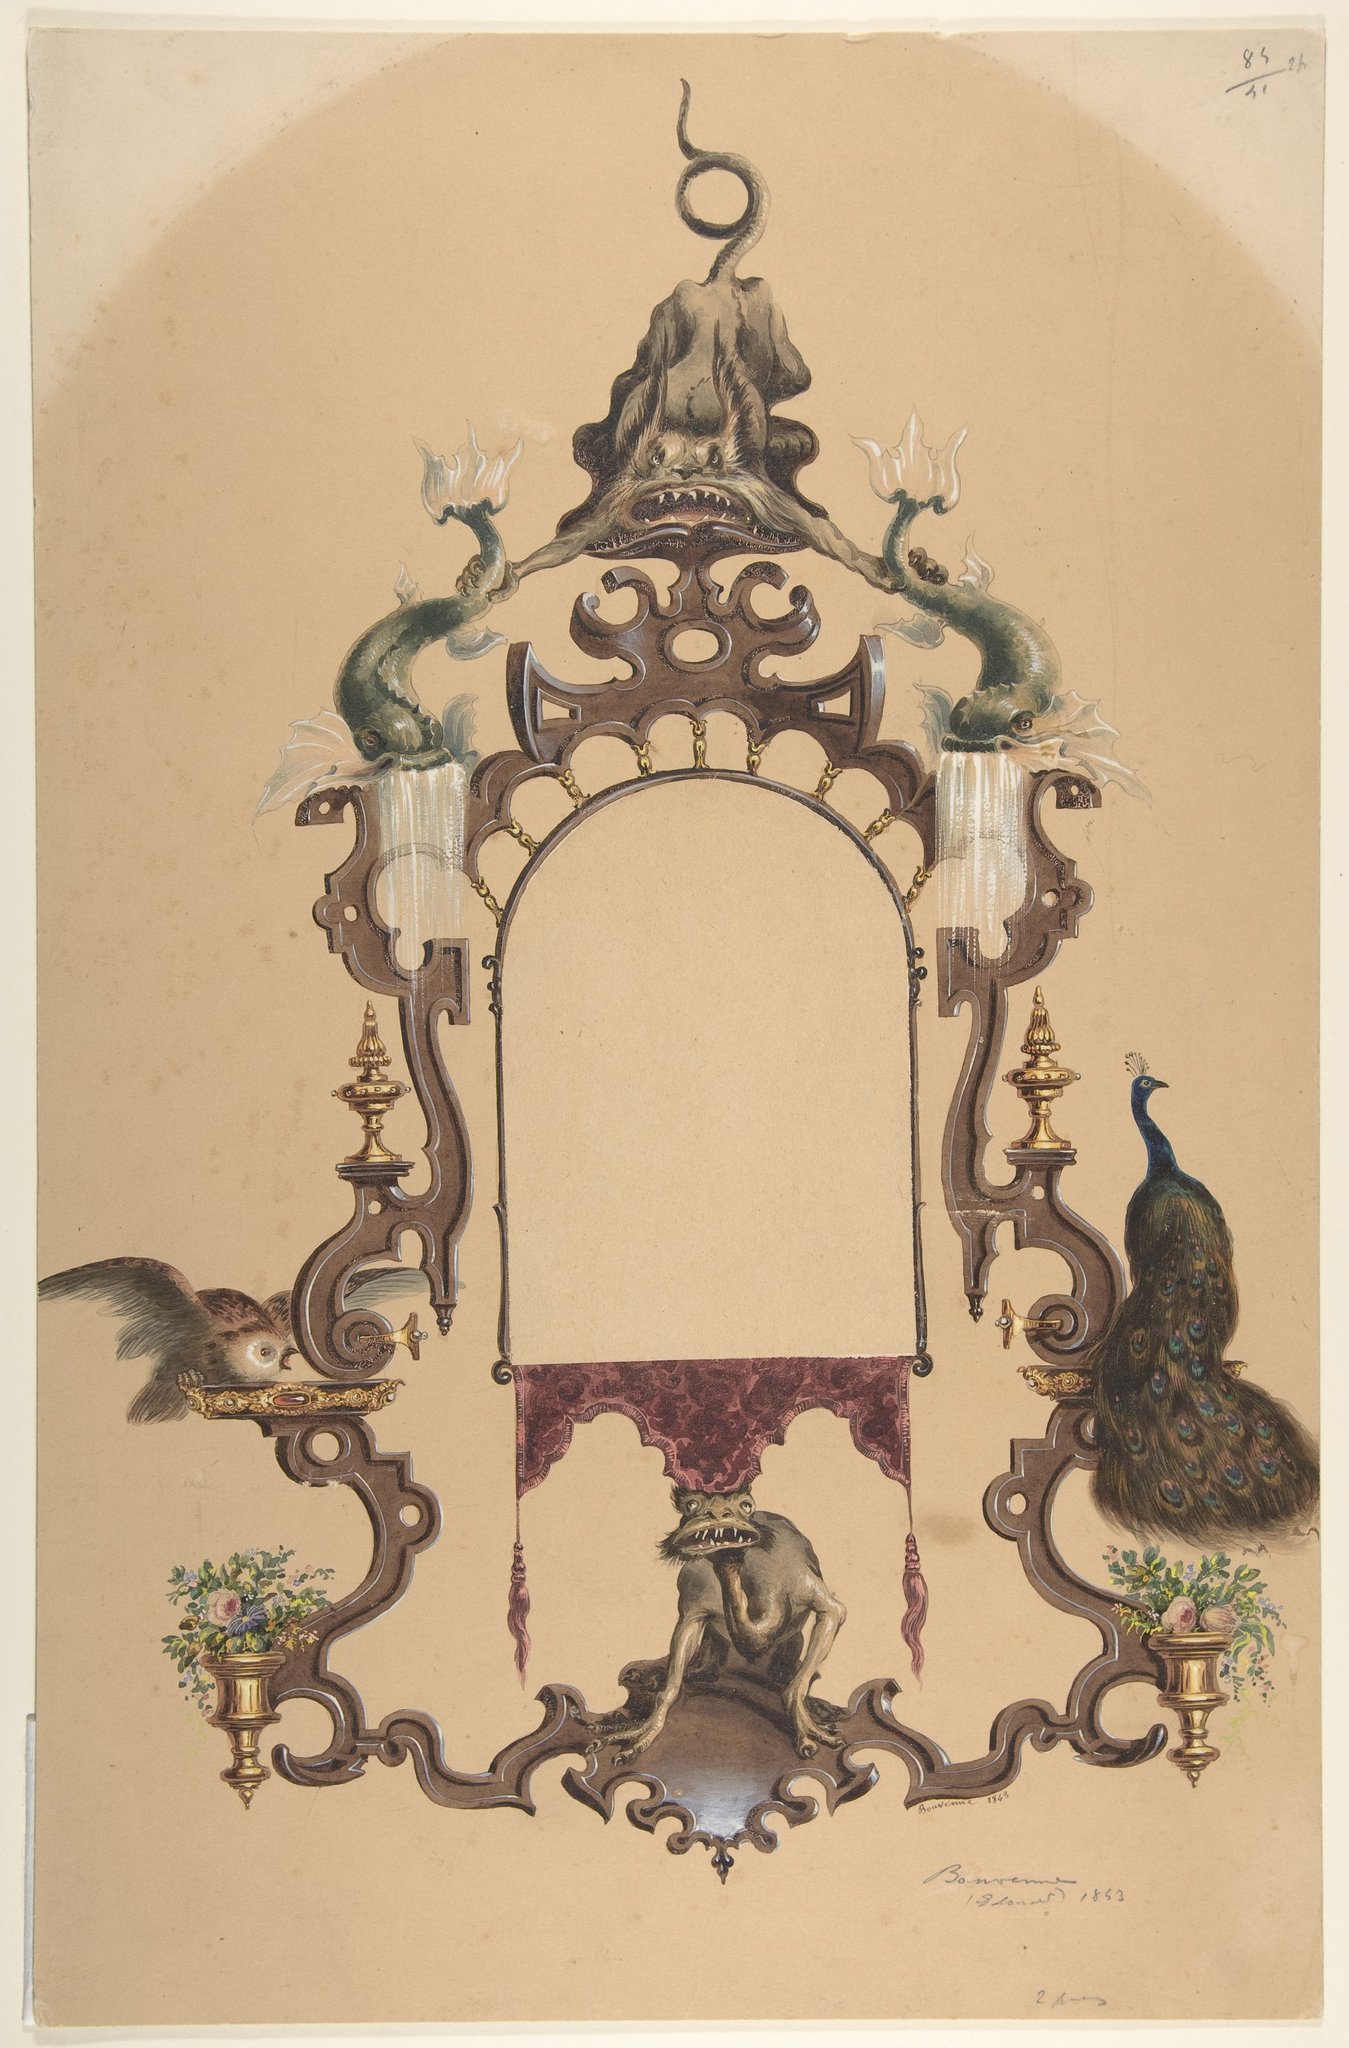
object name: drawing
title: Design for a Frame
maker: edouard [?] bouvenne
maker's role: artist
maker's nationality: french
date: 1843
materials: graphite, paint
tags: owls,peacocks,fish,flowers